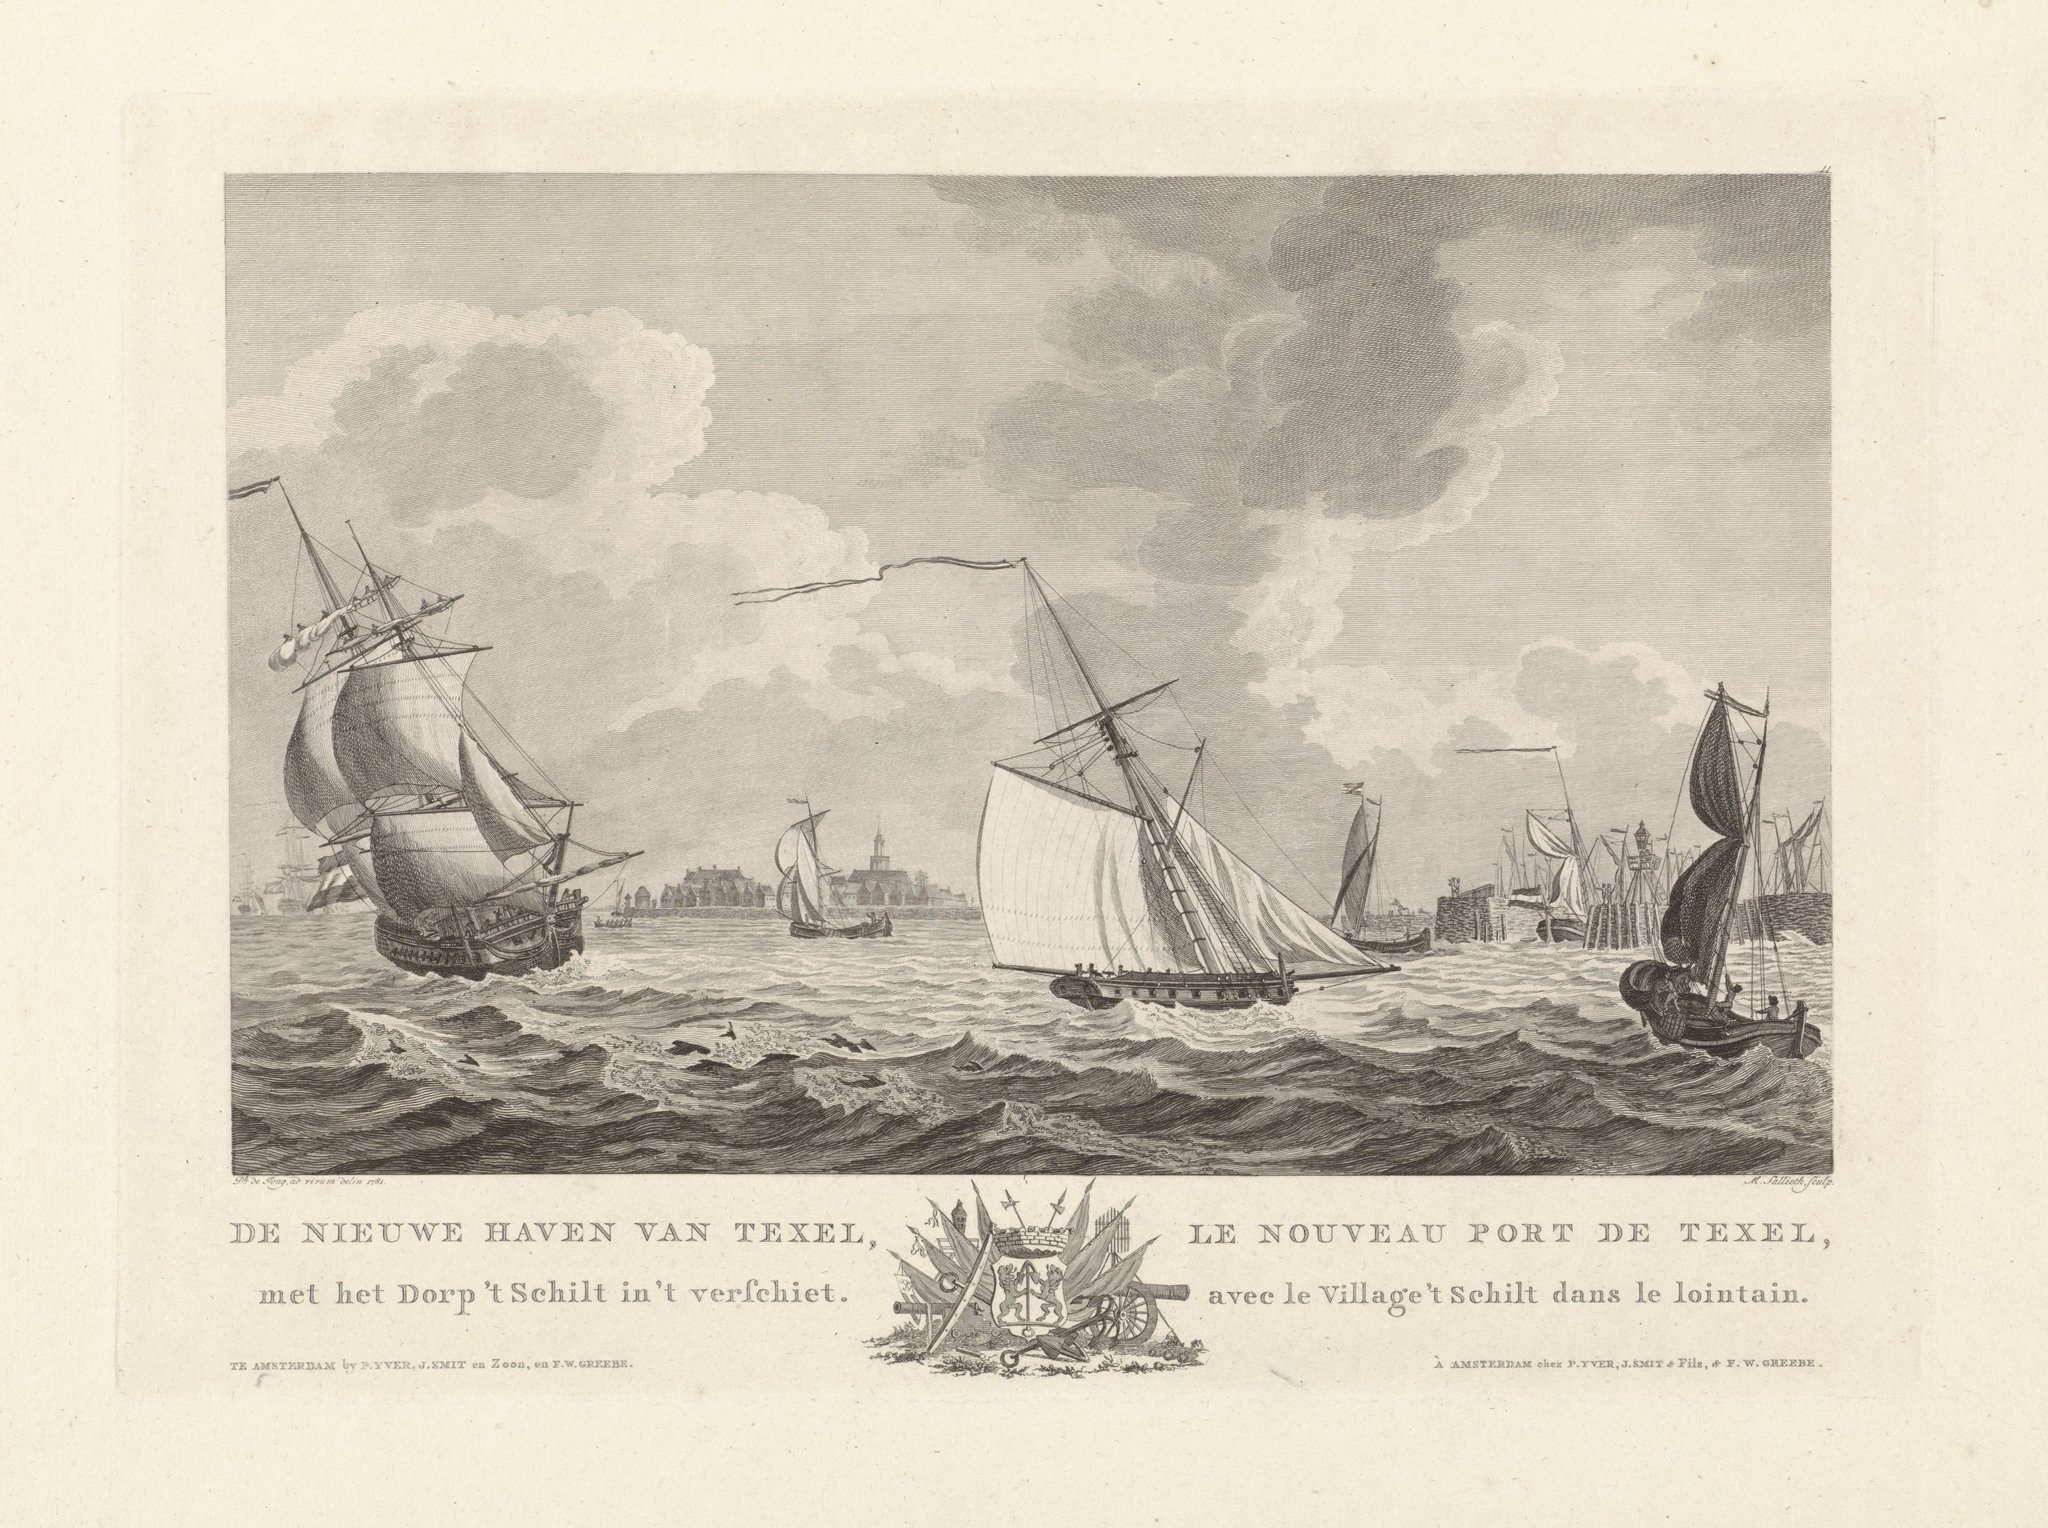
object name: print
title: Gezicht op de Nieuwe Haven van Texel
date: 1781-1787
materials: paper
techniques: etching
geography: amsterdam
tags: harbour, coat of arms (as symbol of the state, etc.), coat of arms (as symbol of the state, etc.) (+ city; municipal), sailing-ship, sailing-boat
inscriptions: collector's mark: Lugt 2228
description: Latere staat ook gebruikt in: Aa, Cornelis van der. Atlas van de zeehavens der Bataafsche Republiek. Met derzelver beschrijvingen in XXXI kunstplaaten / Atlas van de zeehavens der Bataafsche Republiek, die van Batavia en Onrust. Mitsgaders de afbeeldingen van de haringvisscherij en de walvischvangst […]. Amsterdam: Evert Maaskamp, 1805.